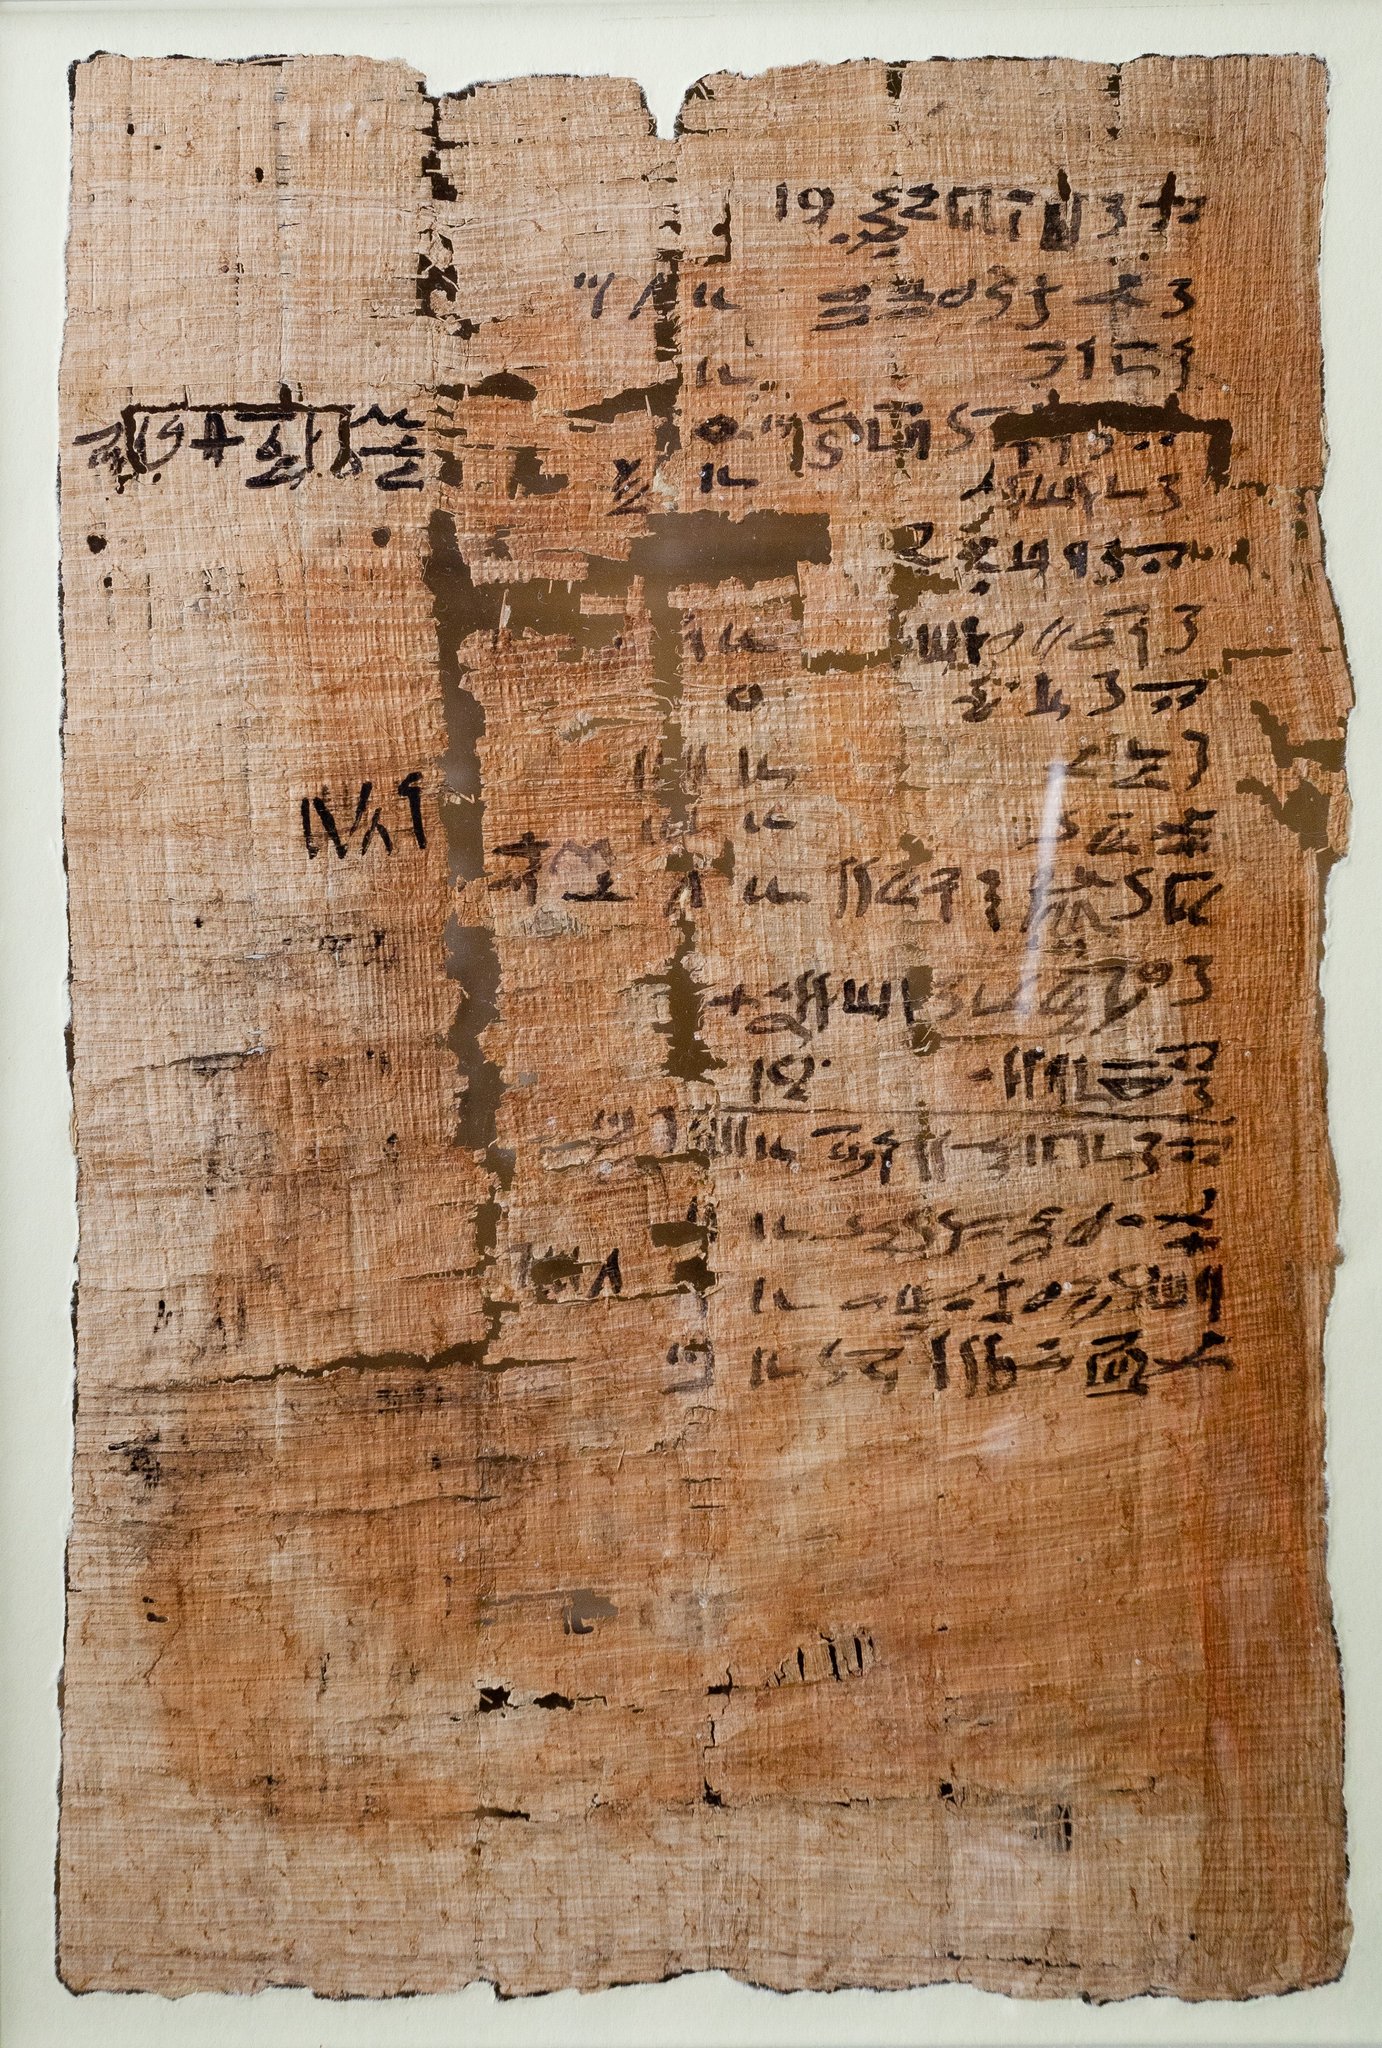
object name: papyrus, letter, heqanakht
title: Heqanakht Account VI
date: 1961-1917 BCE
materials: ink, papyrus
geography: egypt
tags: documents,hieratic